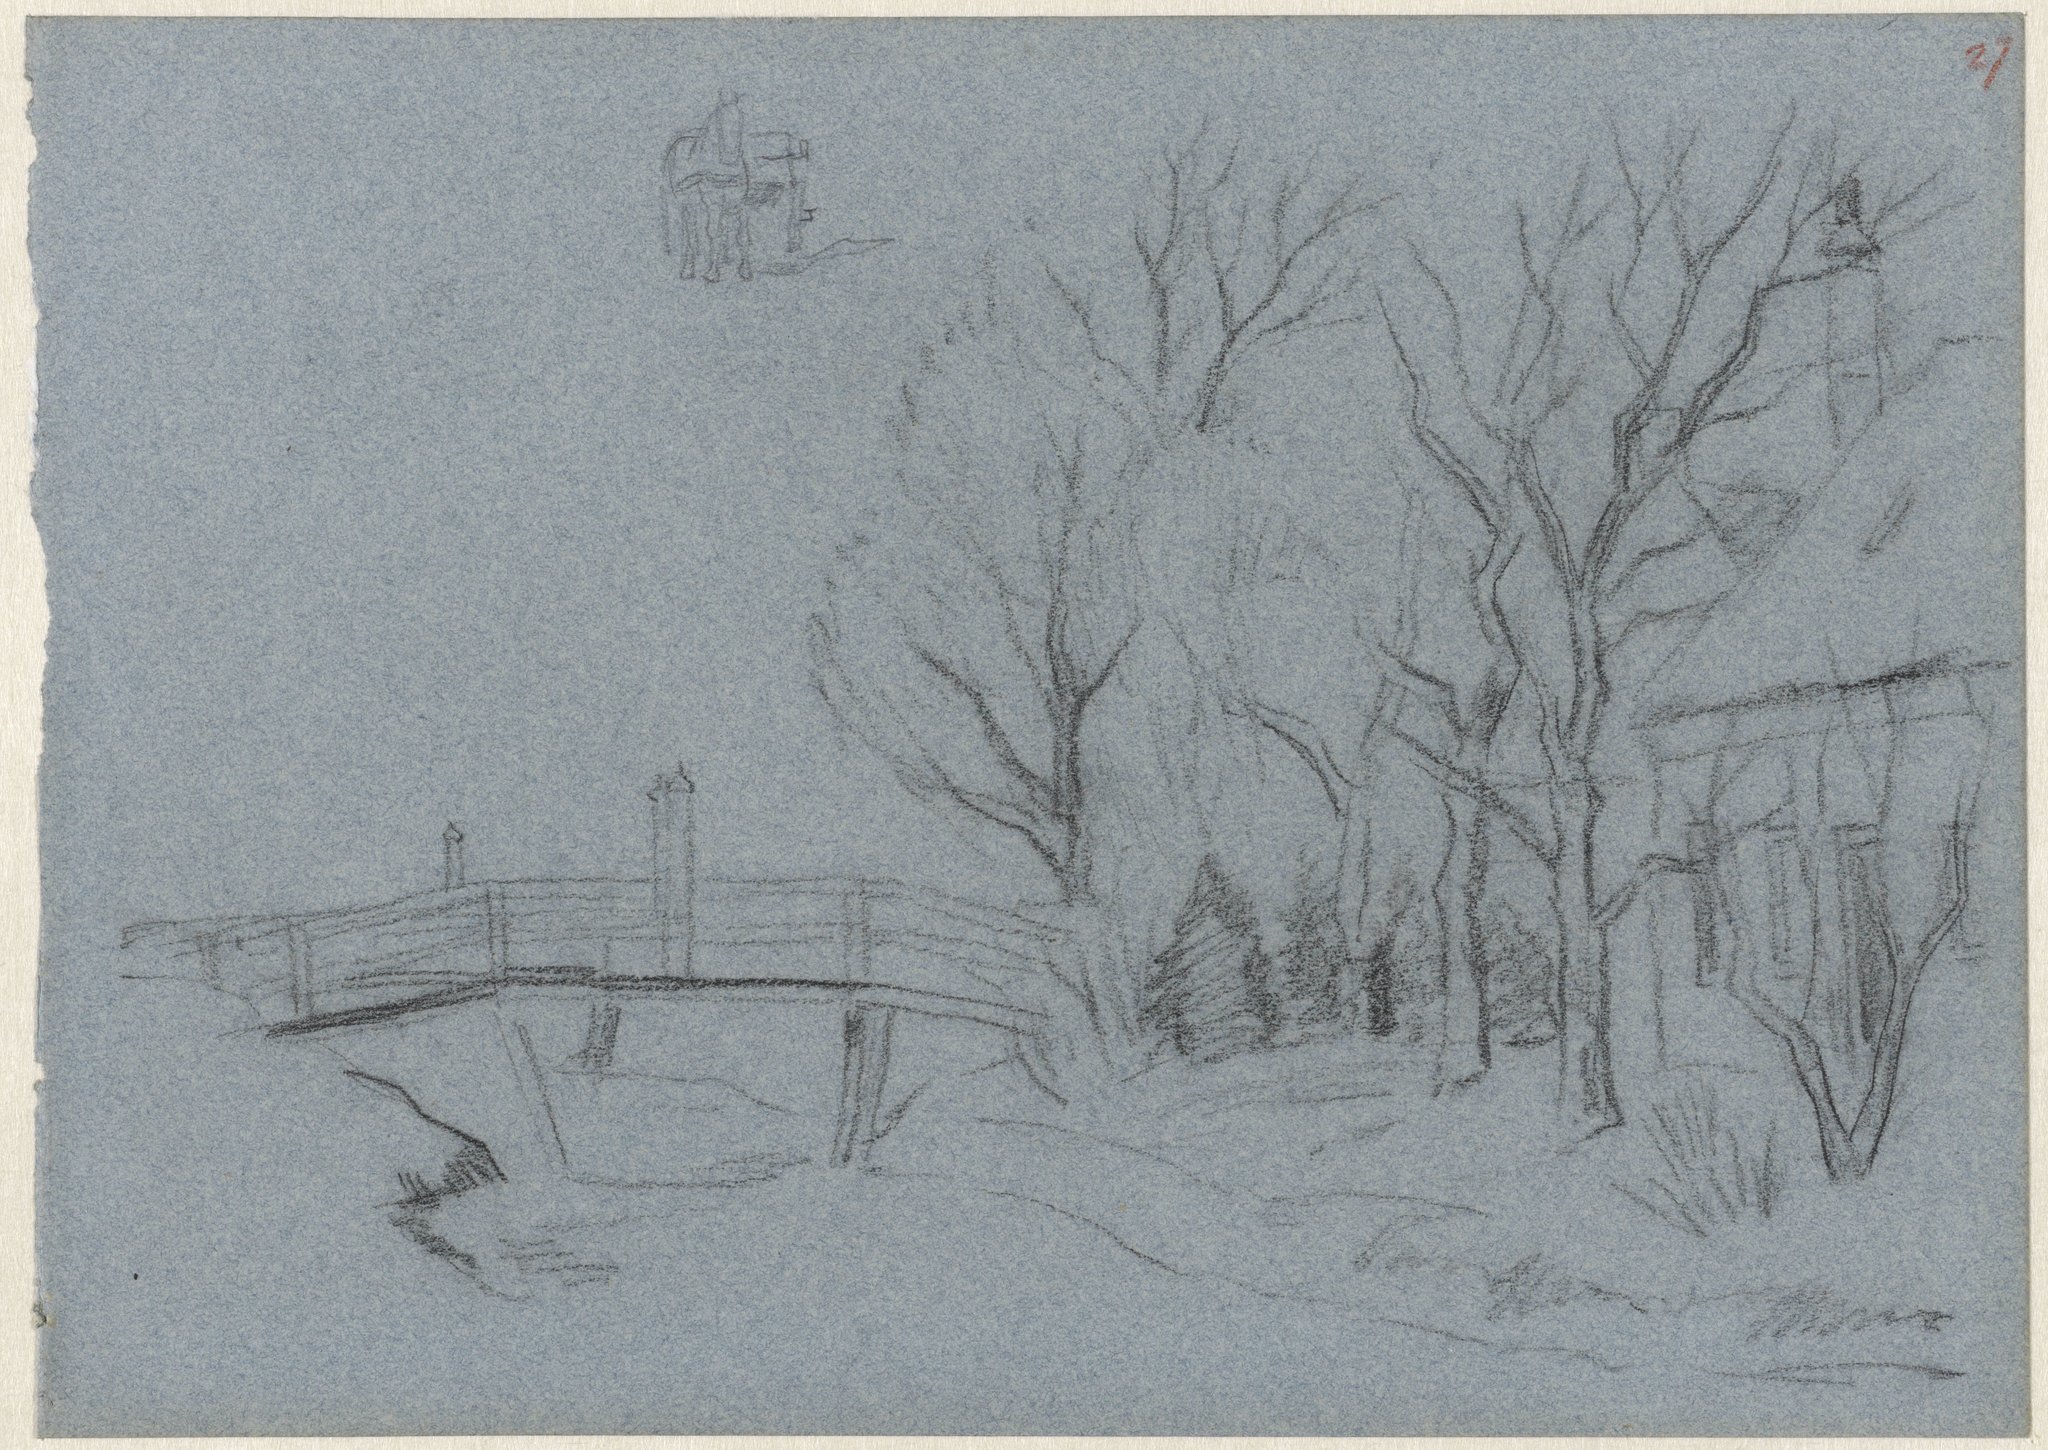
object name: drawing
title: Bruggetje en bomen bij een huis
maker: jozef israëls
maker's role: draughtsman, painter, print maker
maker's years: 1824-1911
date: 1834-1911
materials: chalk, paper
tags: rural housing, e.g. country-house, villa, cottage